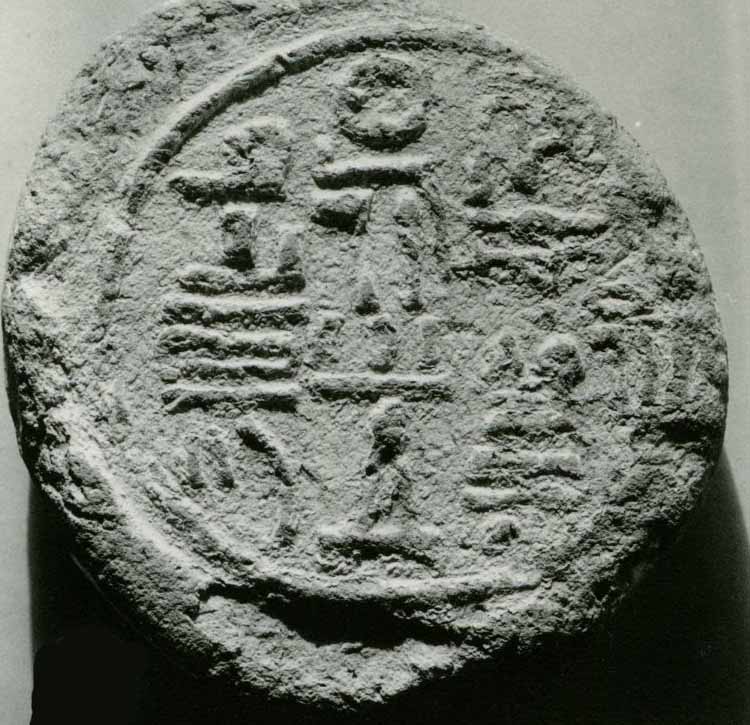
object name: cone, min, circular impression, overseer, onuris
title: Funerary Cone of the Overseer of the Prophets of Onuris Min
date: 1479-1425 BCE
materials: pottery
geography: egypt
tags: hieroglyphs